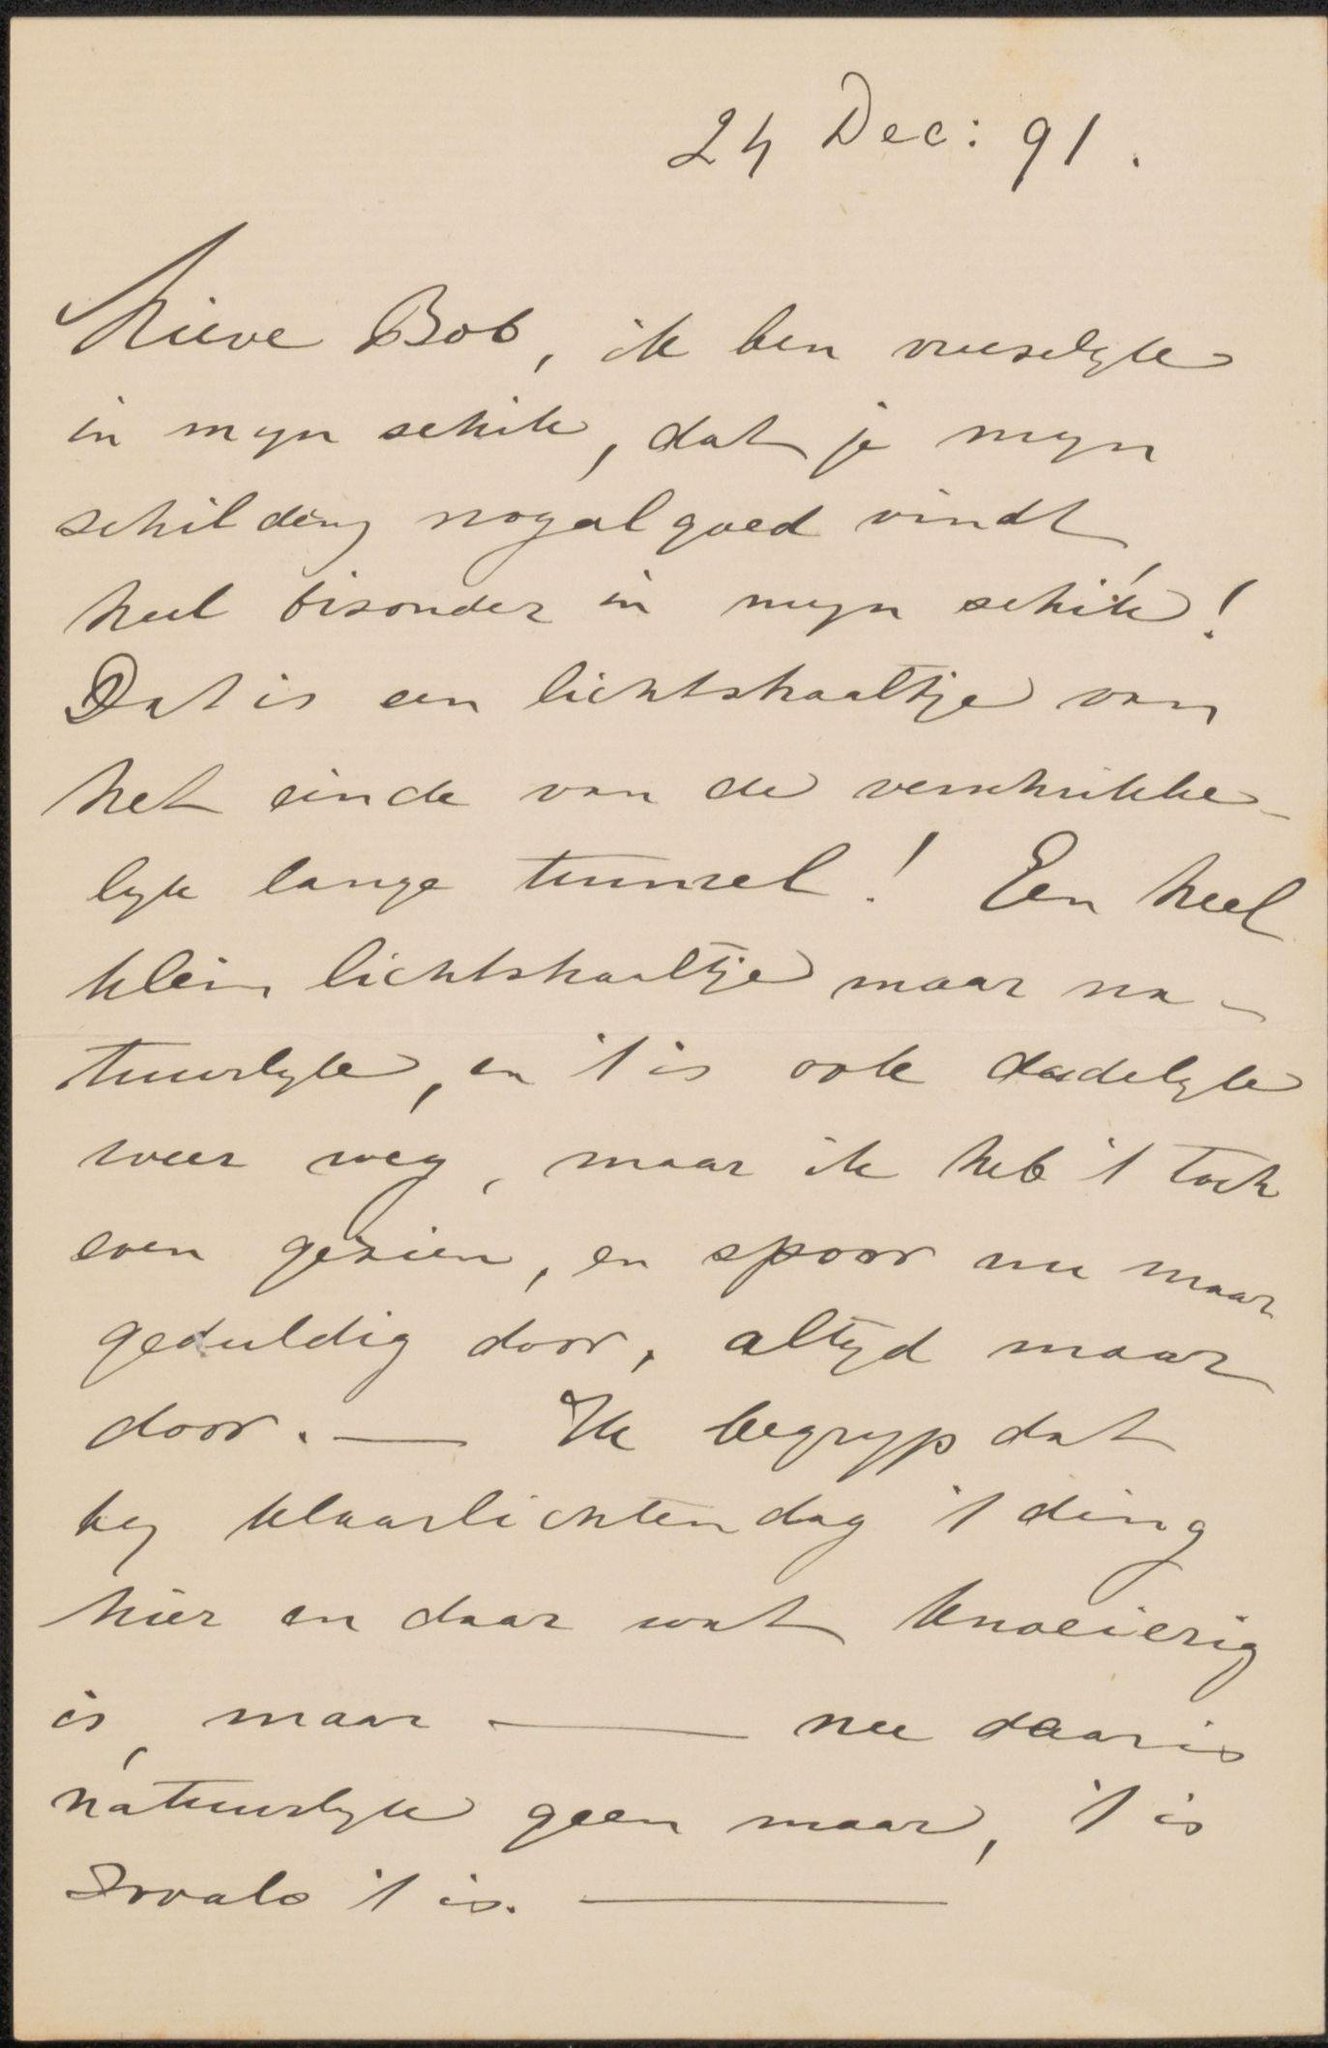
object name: letter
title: Brief aan Jan Veth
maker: wally moes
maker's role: draughtsman, print maker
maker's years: 1856-1918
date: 1874-1918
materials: ink, paper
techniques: pen, writing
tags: painter, designer, jan veth, painting (including book-illumination, miniature-painting)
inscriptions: collector's mark: ‘RPK’